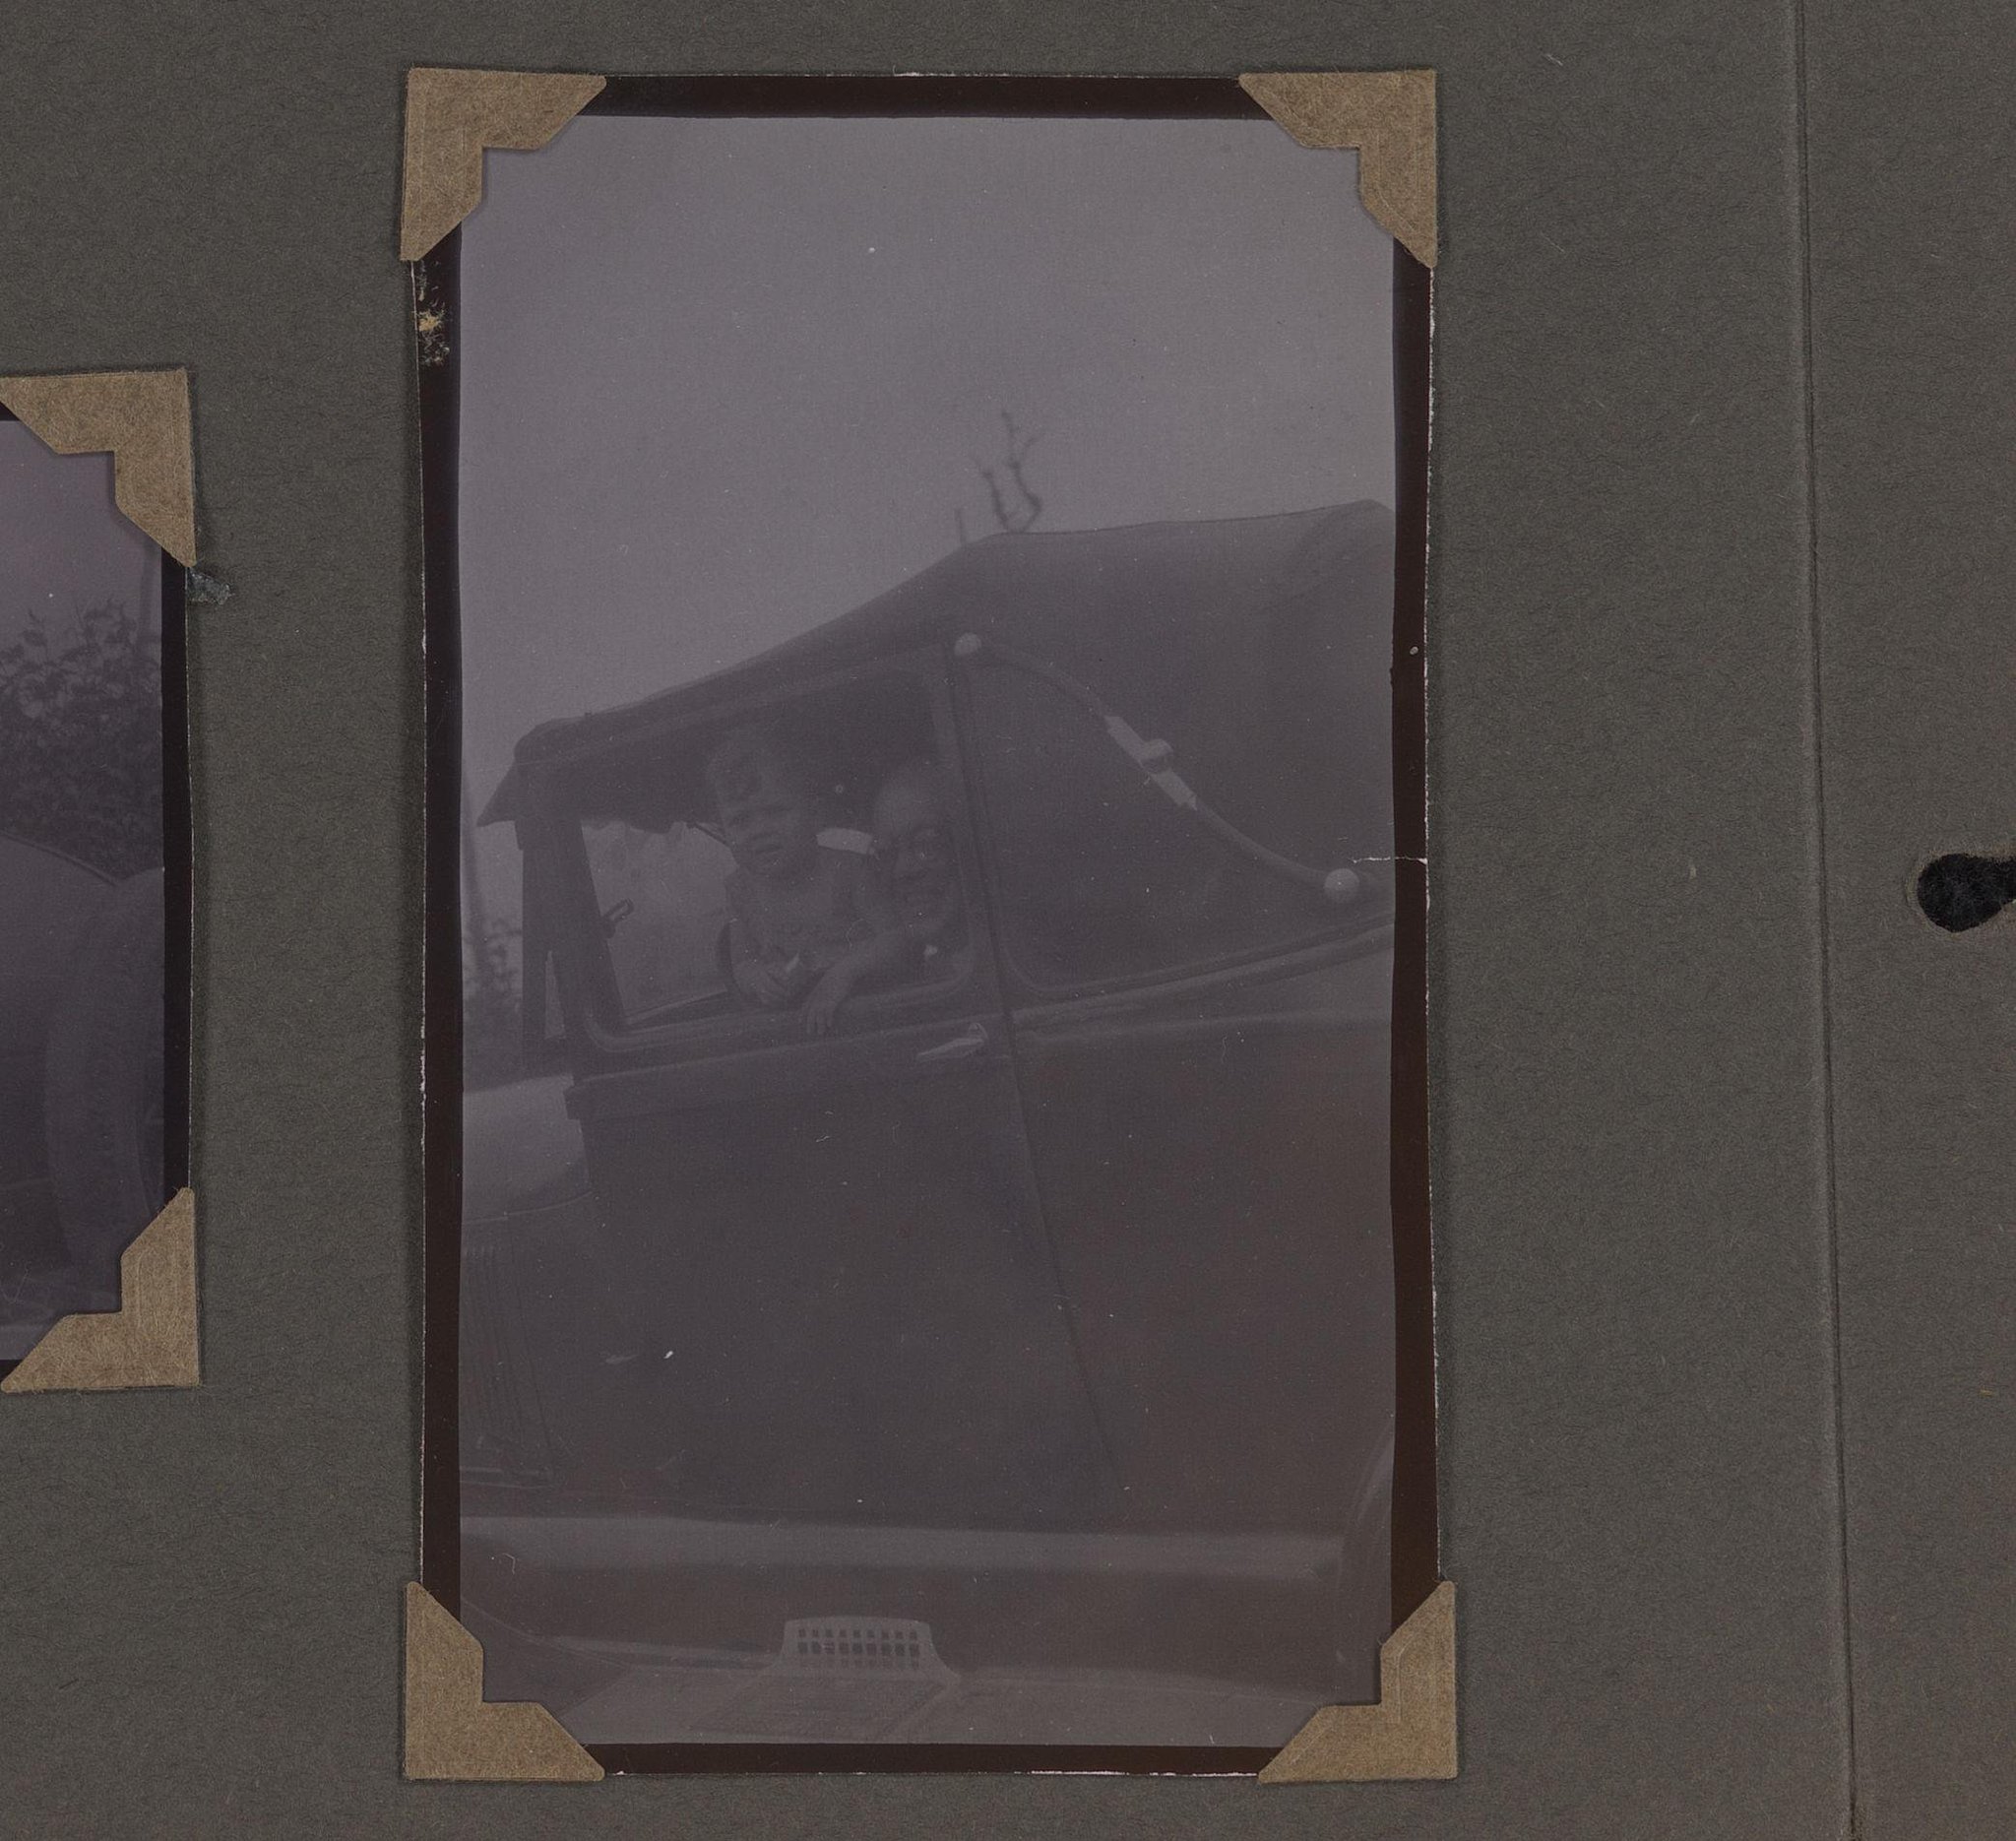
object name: photograph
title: Familiefoto van het gezin Jetten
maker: Anonymous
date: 1925-1927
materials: photographic support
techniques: photography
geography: suriname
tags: jetten, familie, moengo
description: Familiefoto van de kinderen Jetten in Suriname. Foto op een bladzijde van een los albumblad. Onderdeel van het ensemble met foto's van de familie van ingenieur Jetten in de mijnbouwstad Moengo in Suriname.